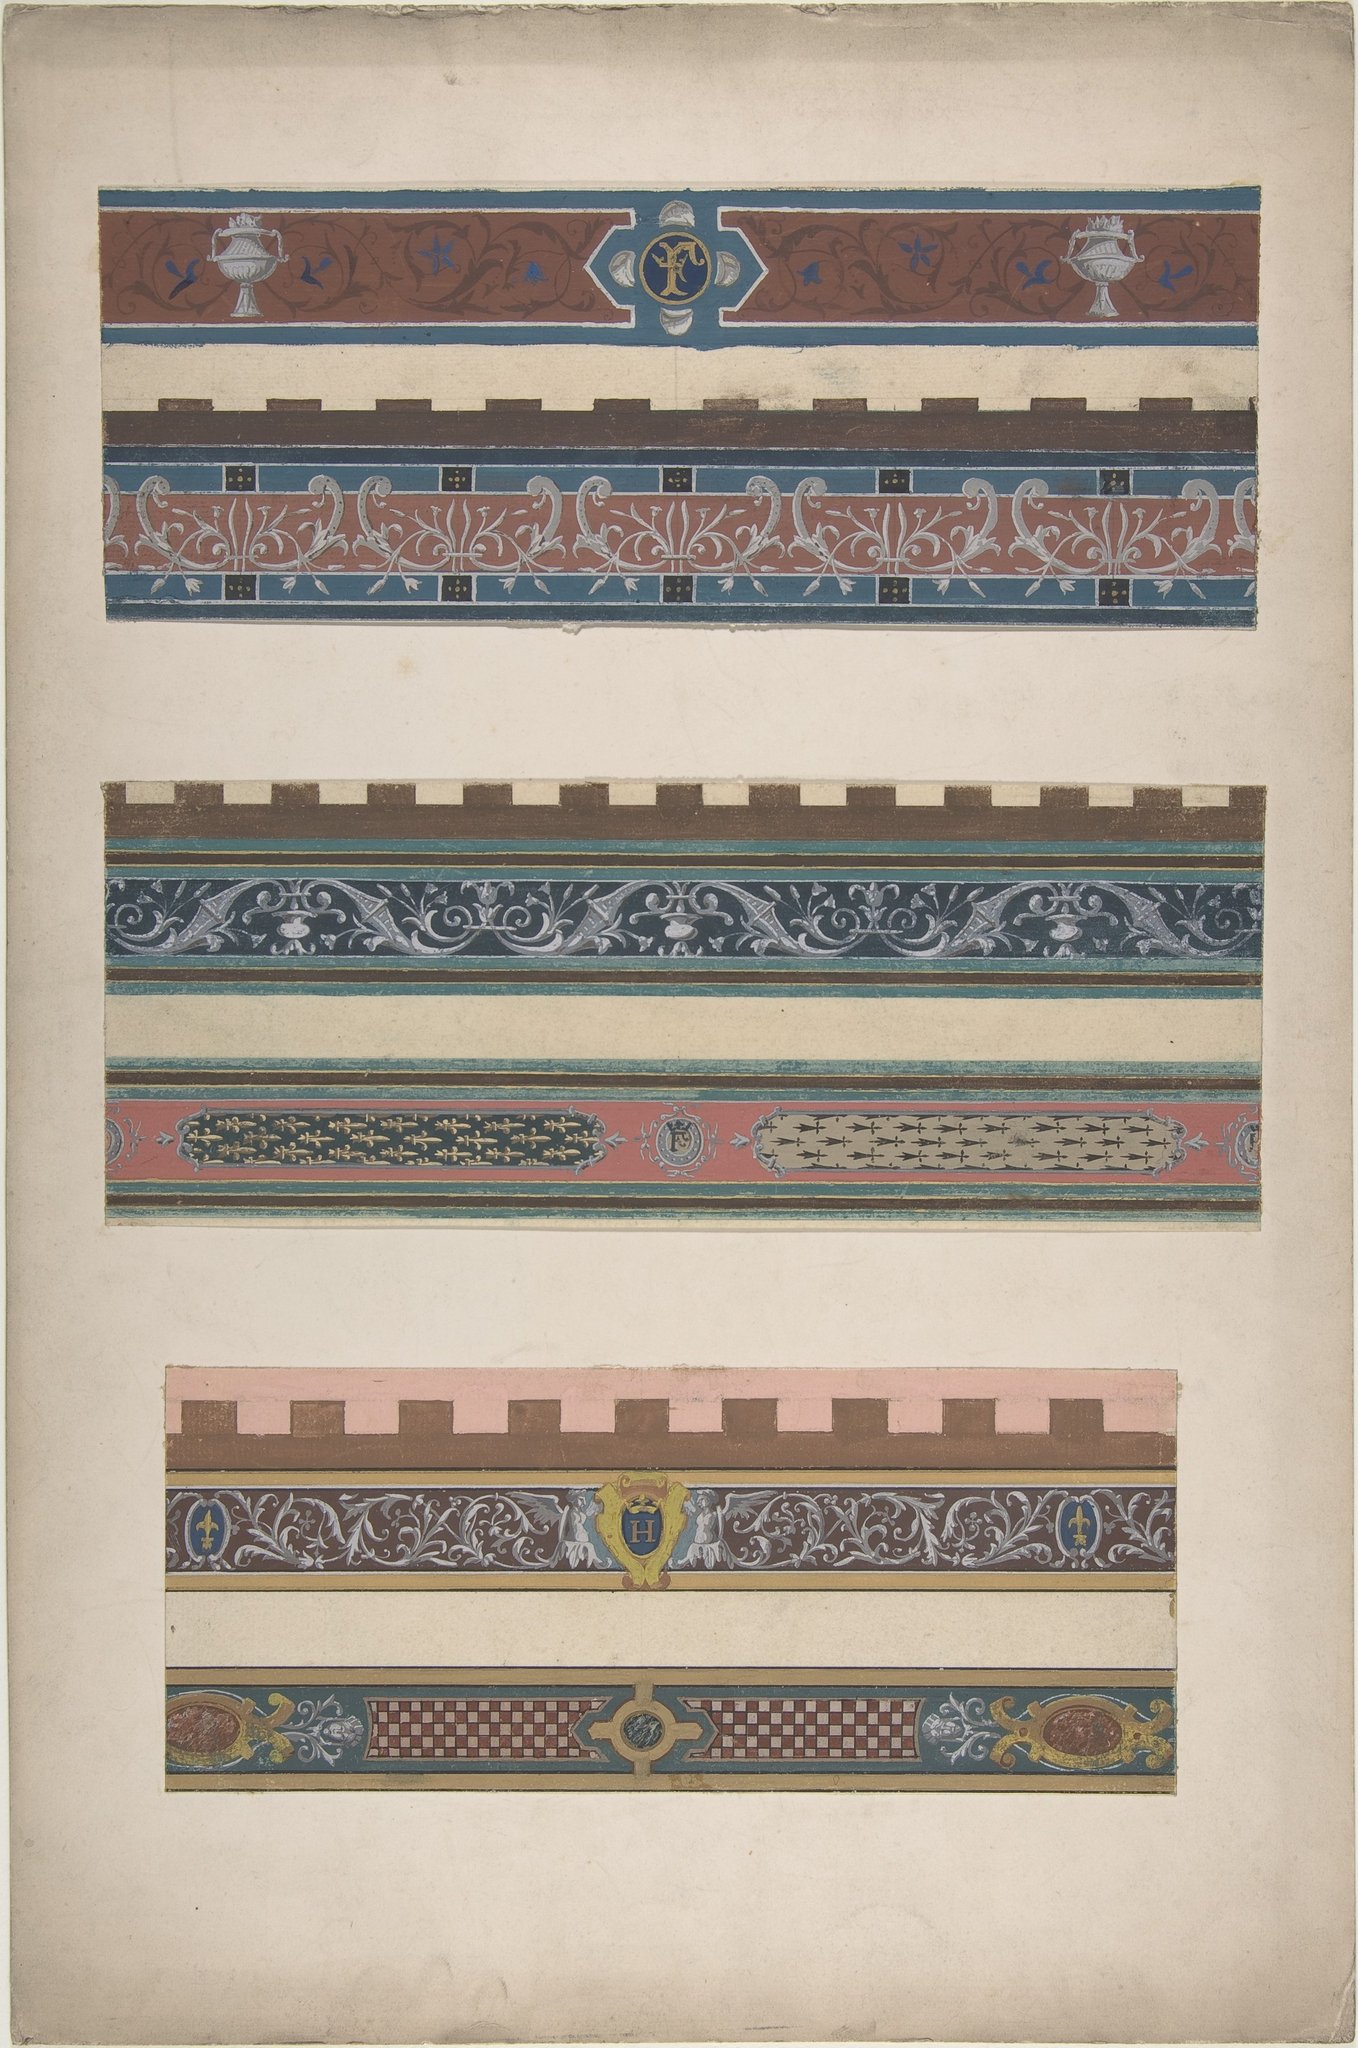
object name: drawing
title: Design for Ceiling at Fontainebleau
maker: jules-edmond-charles lachaise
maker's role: artist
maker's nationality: french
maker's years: 1897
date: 1851-1900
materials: gouache, graphite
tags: ceilings